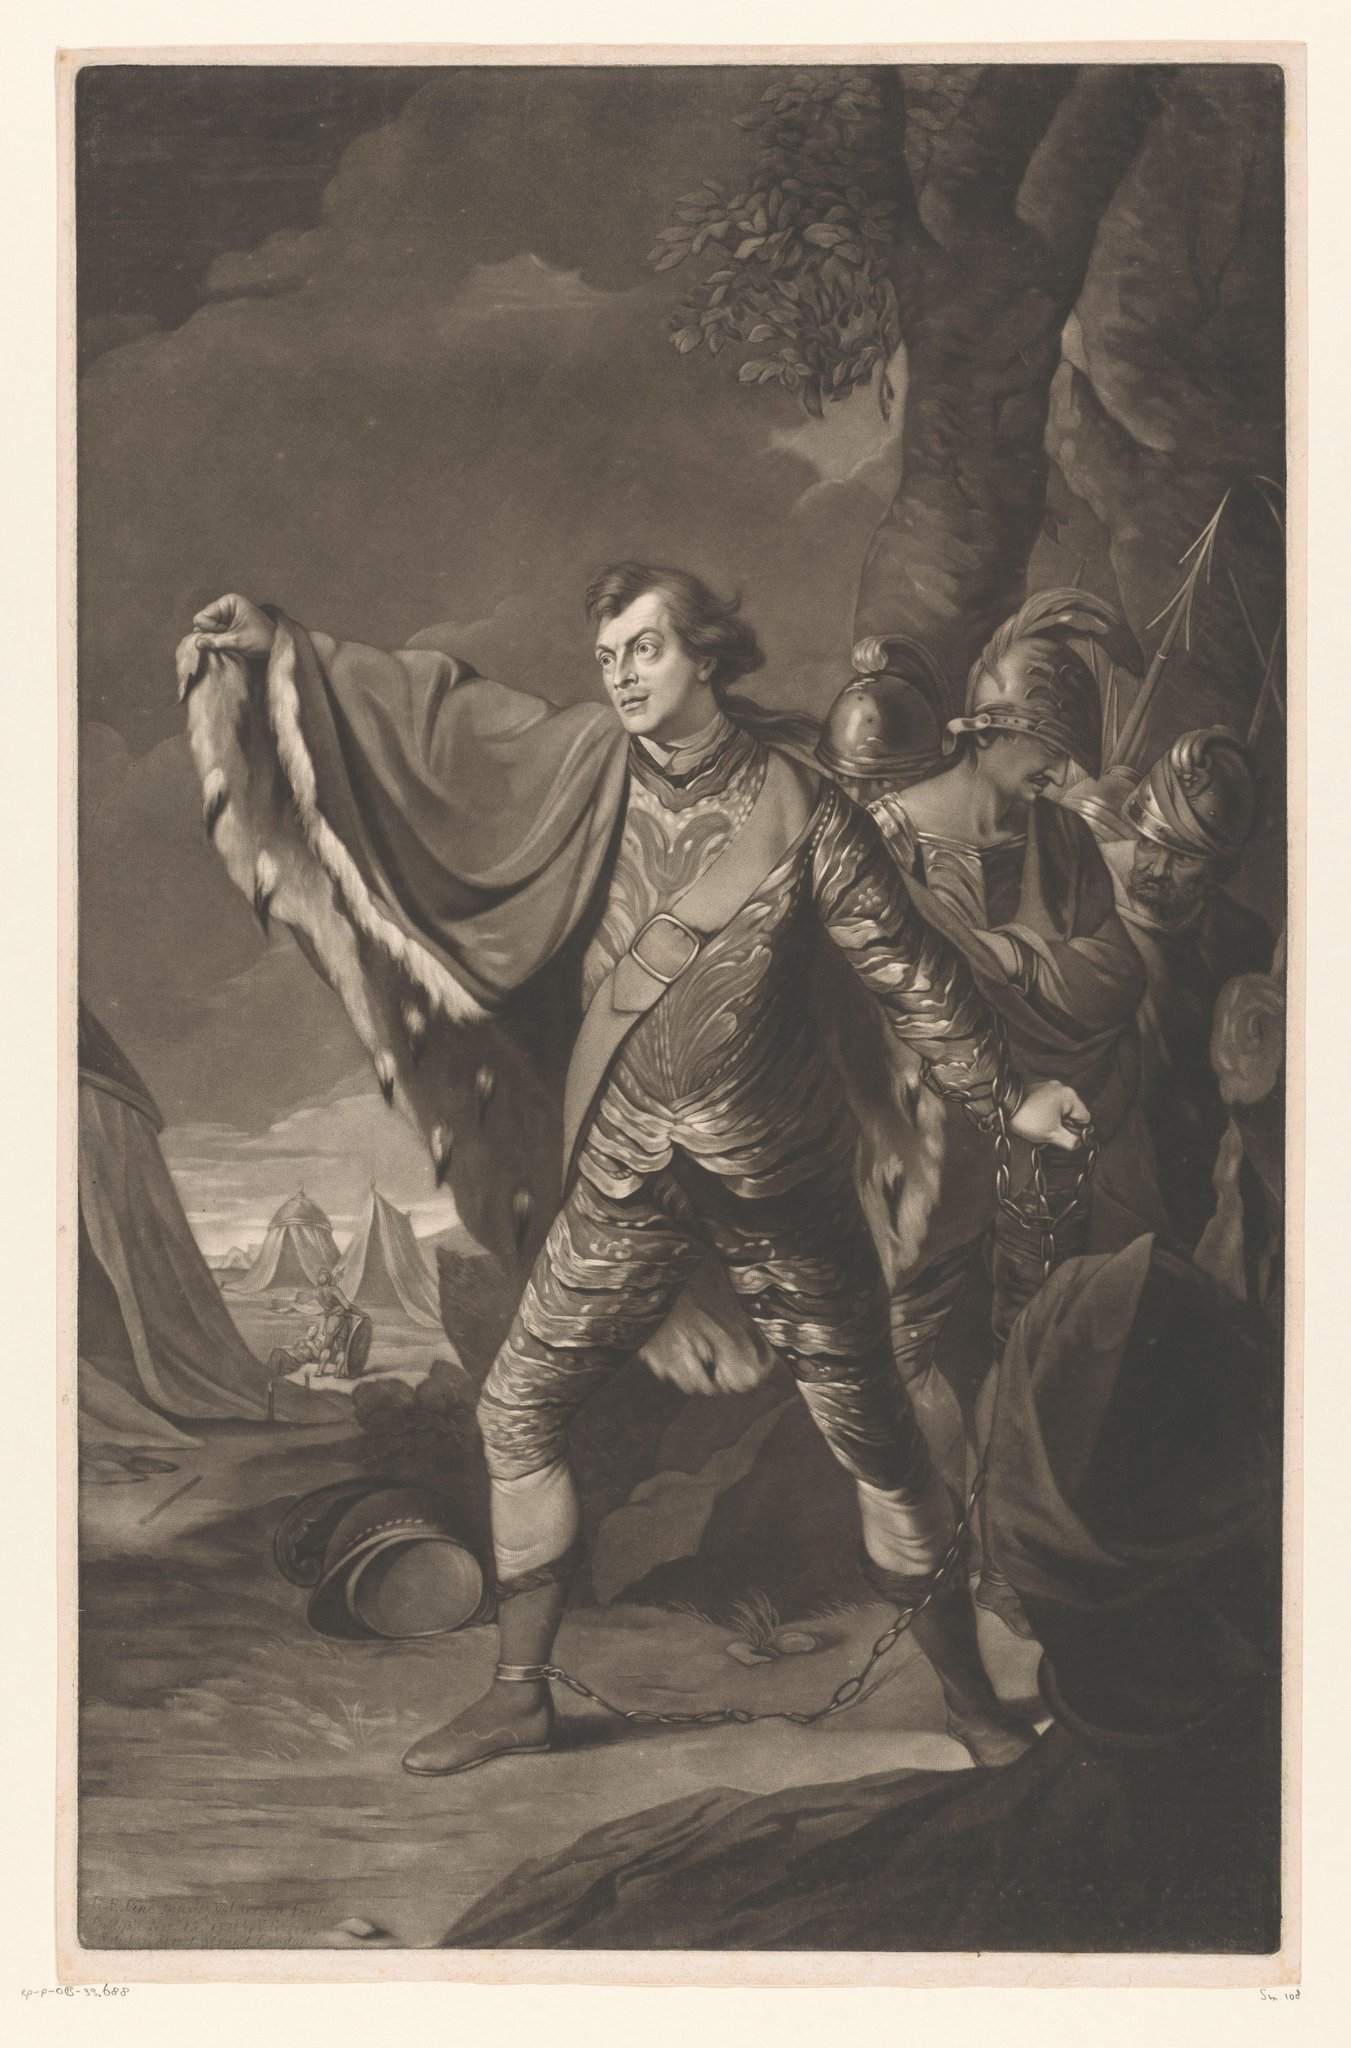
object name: print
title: Portret van Samuel Reddish als Posthumus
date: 1711-1771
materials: paper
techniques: mezzotint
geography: london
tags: portrait of actor, actress (+ artist at work), (military) camp with tents, historical persons, the soldier; the soldier's life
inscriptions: collector's mark: Lugt 240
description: Portret van de acteur Reddish als Posthumus uit Shakespeares Cymbeline.